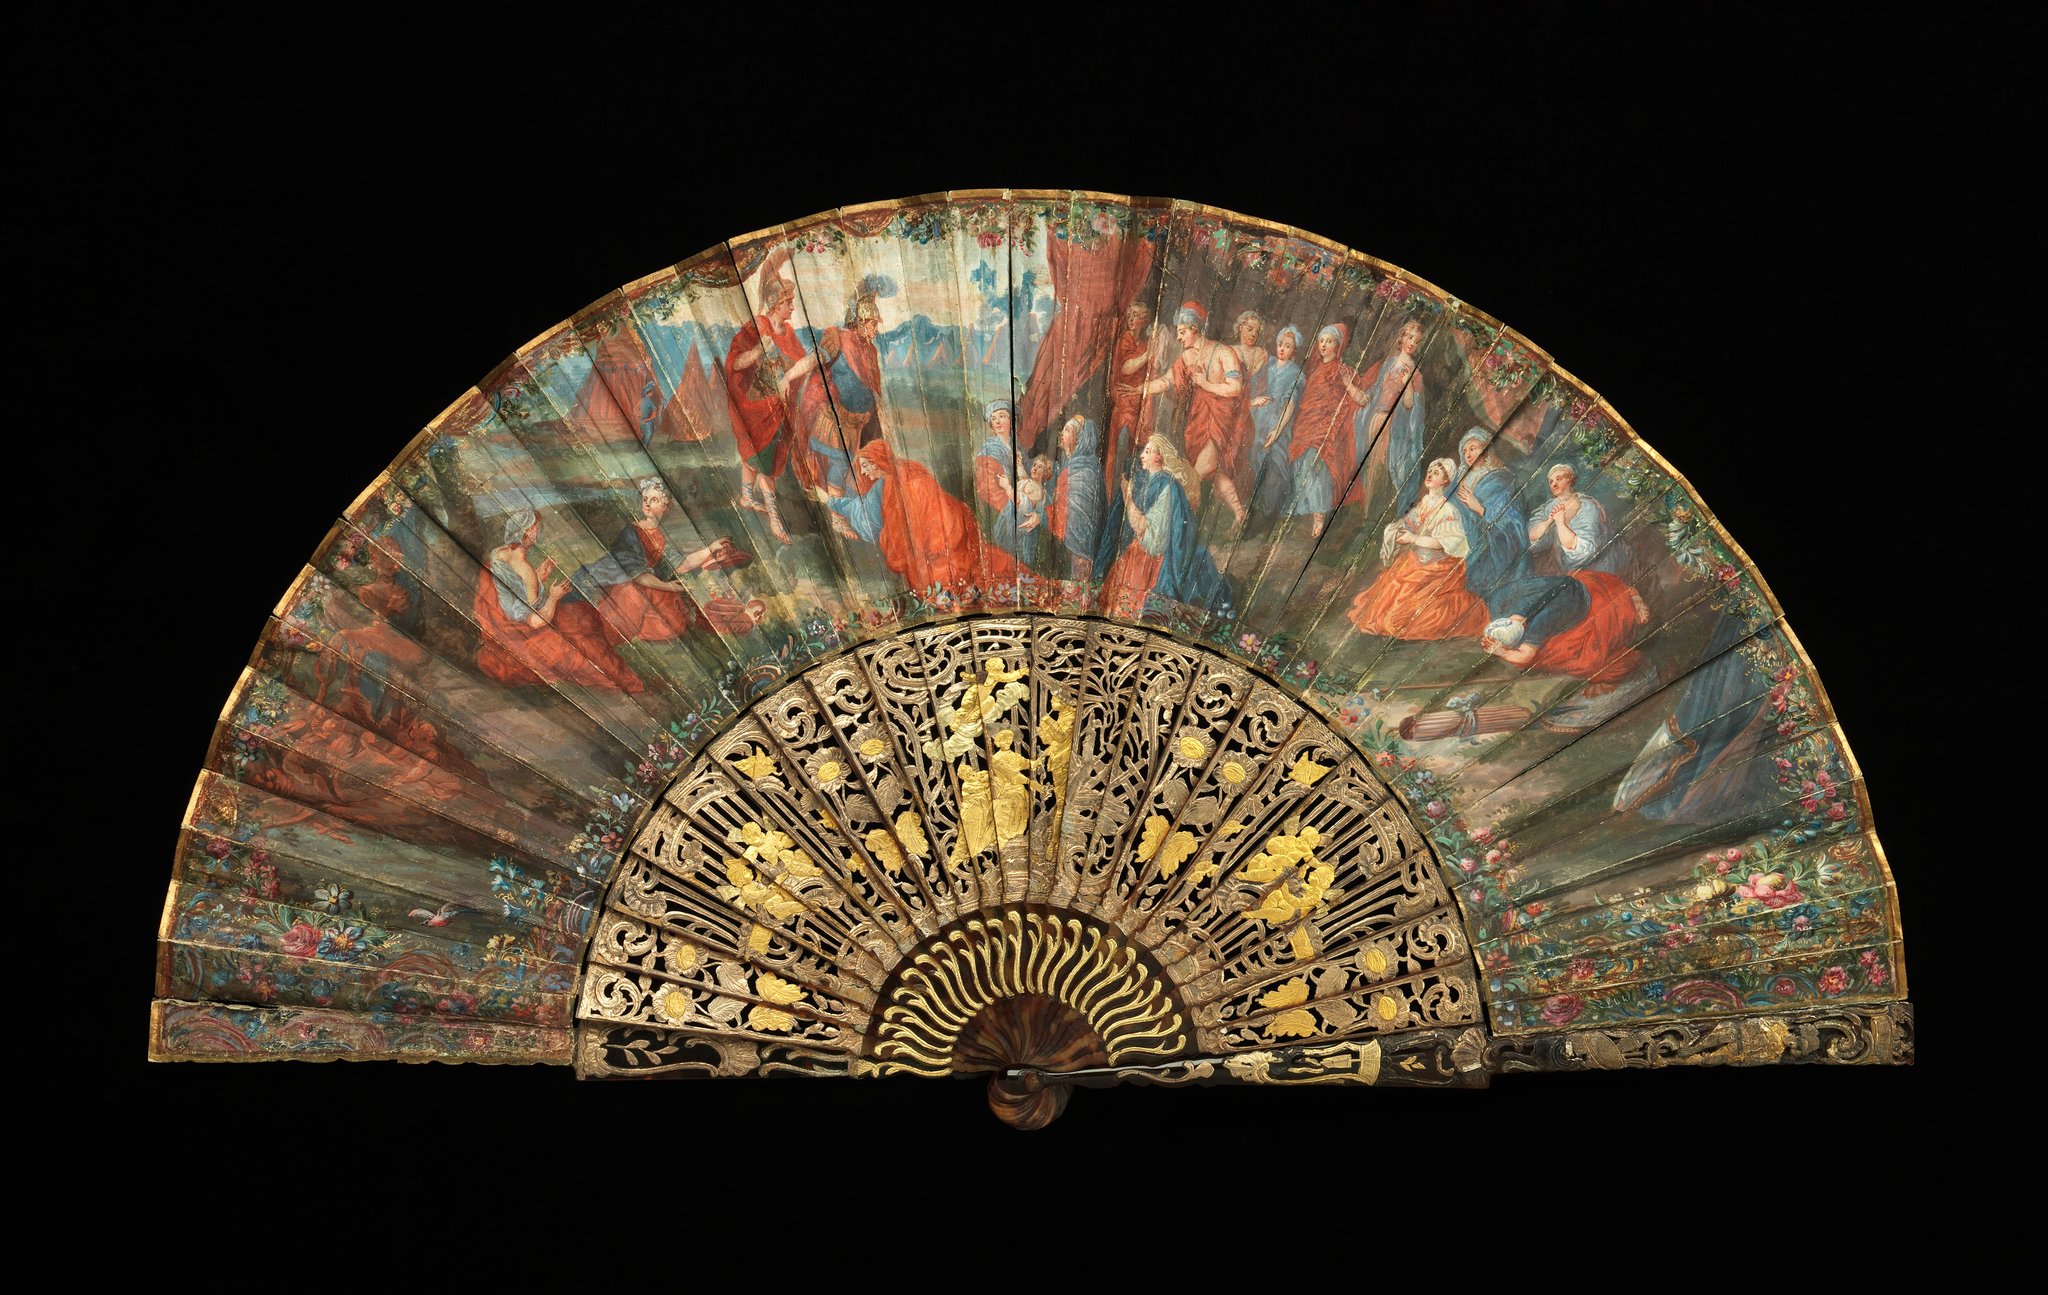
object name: fan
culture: italian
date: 1740-1760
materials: gouache, metal, paper, shell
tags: men,women,flowers